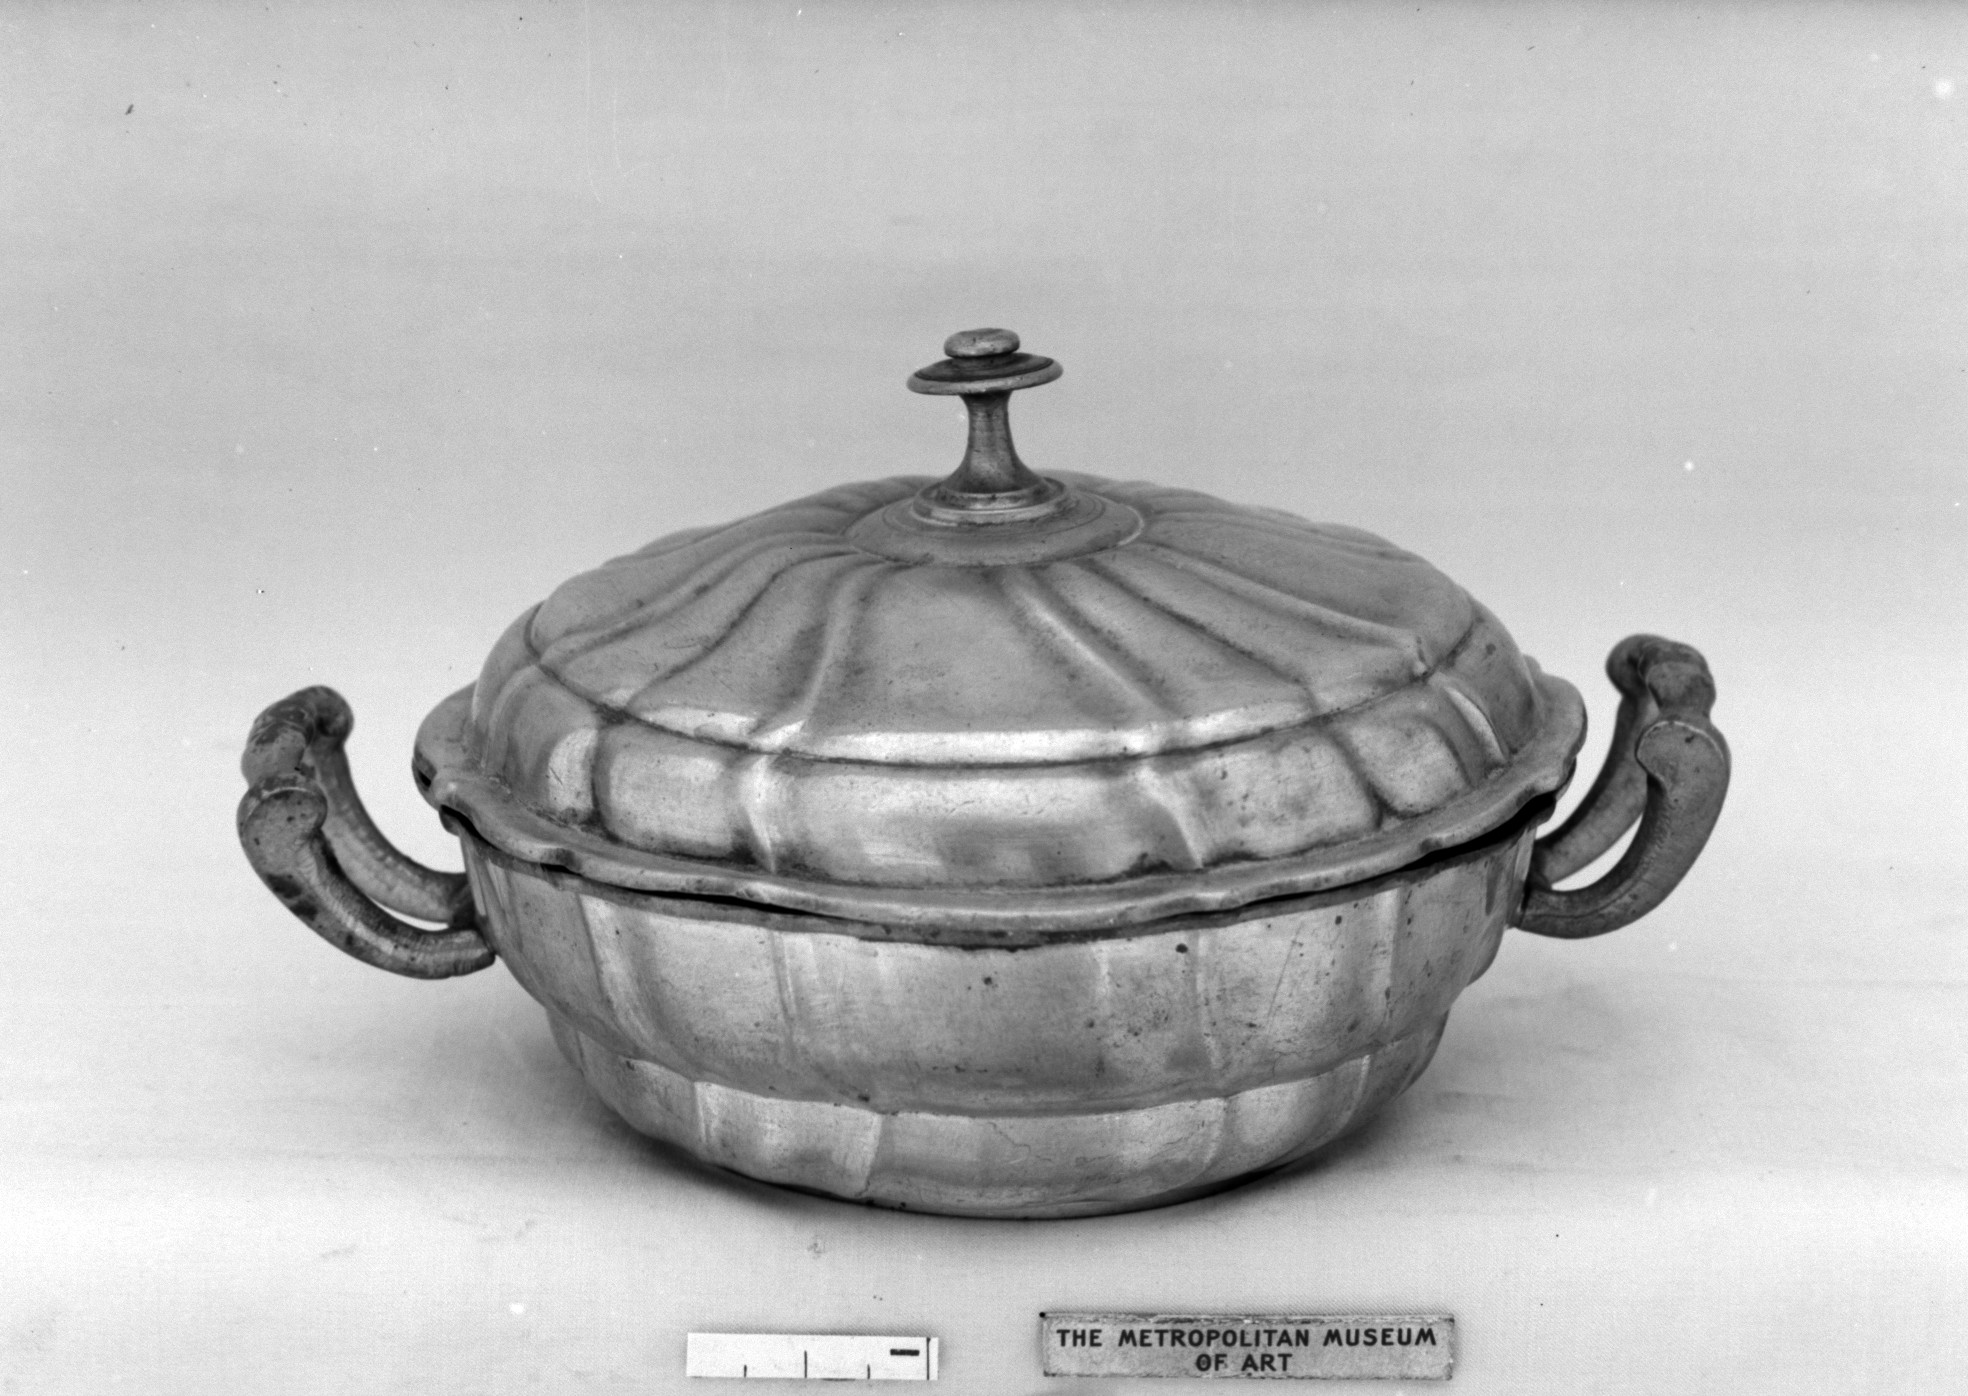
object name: broth bowl with cover écuelle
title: Broth bowl with cover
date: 1701-1800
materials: pewter